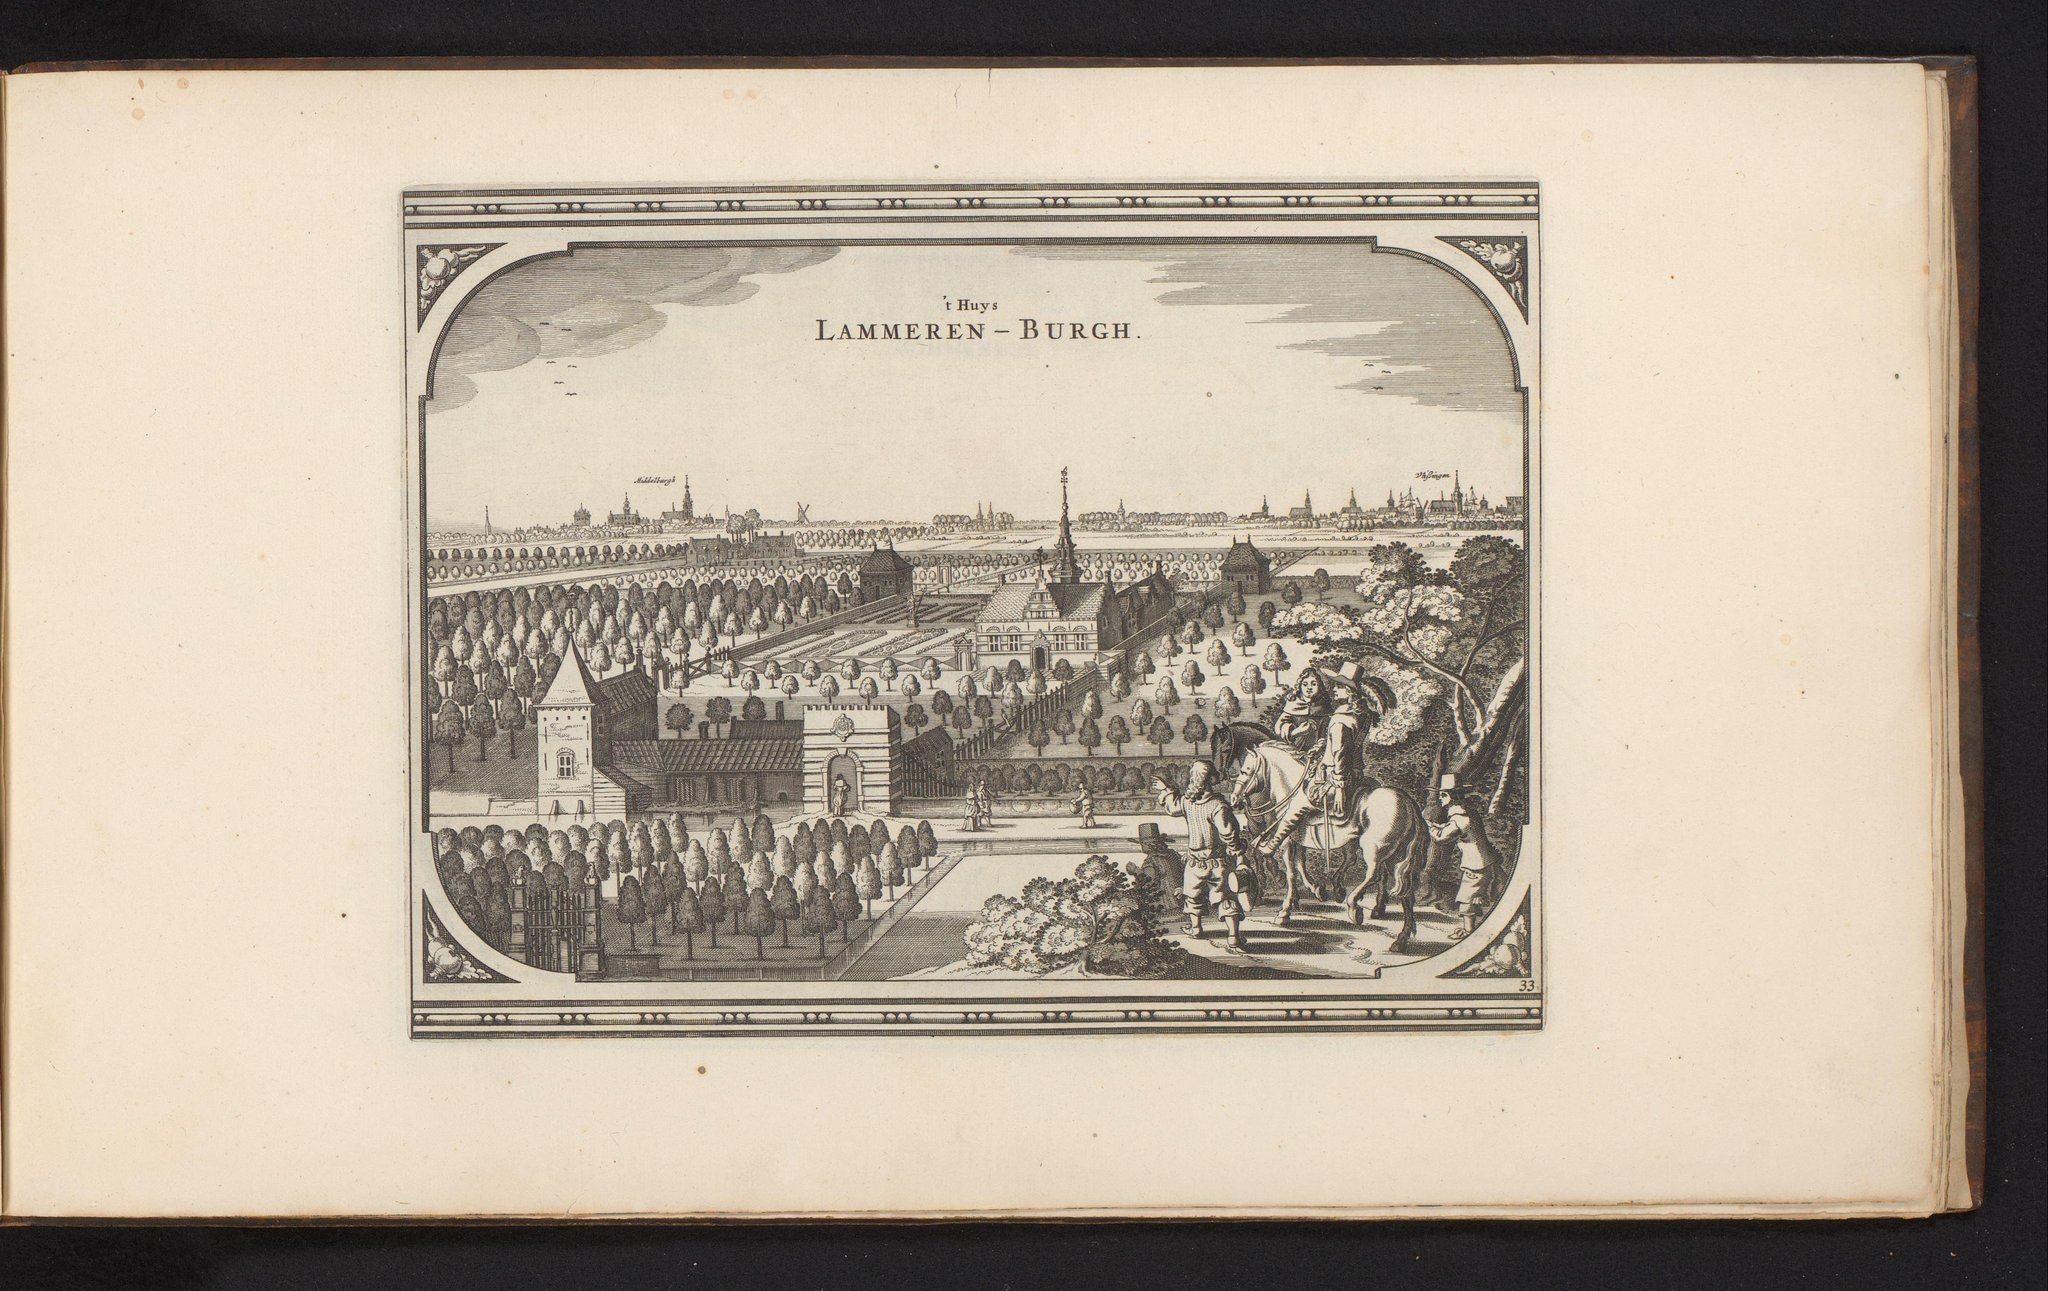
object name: album leaf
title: Gezicht op Huis Lammerenburg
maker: pieter hendricksz. schut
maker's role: print maker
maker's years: 1618-1660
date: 1662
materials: paper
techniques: etching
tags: city-view, and landscape with man-made constructions, rural housing, e.g. country-house, villa, cottage, index finger forwards, pointing, indicating, middelburg, flushing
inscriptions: collector's mark: Lugt 195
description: Gezicht op buitenplaats Lammerenburg. In de verte liggen de steden Middelburg en Vlissingen. Op de voorgrond rechts wordt een welgesteld paar te paard de weg naar de hofstede gewezen. De prent maakt deel uit van een album.